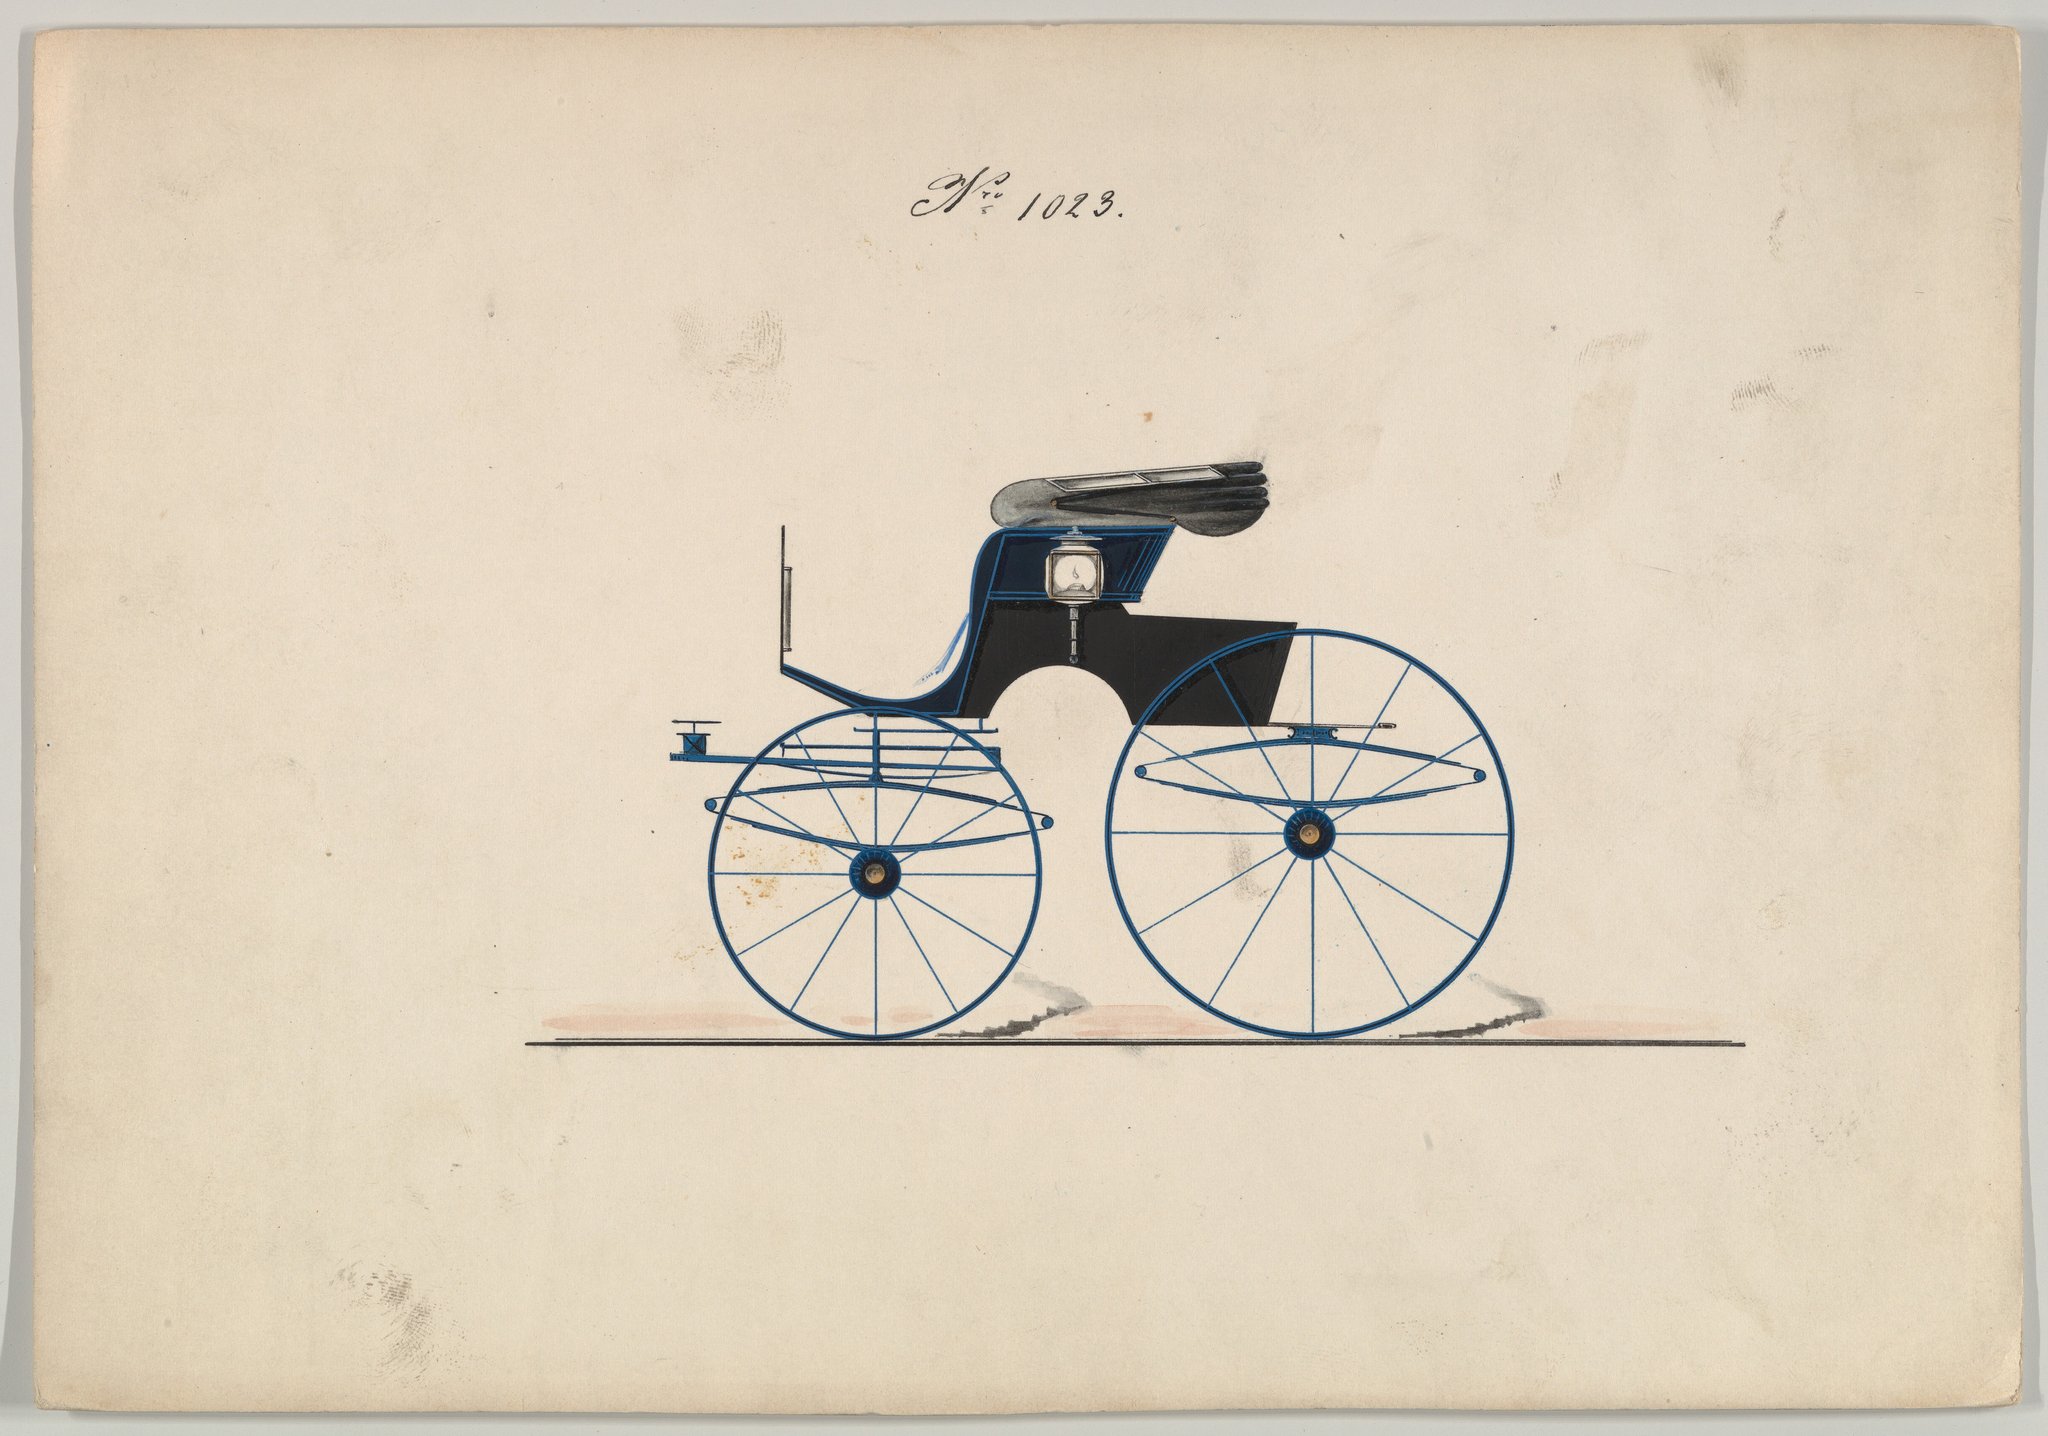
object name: drawing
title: Design for Unclassified Carriage, no. 1023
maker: brewster & co.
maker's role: manufacturer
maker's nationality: american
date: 1850-1870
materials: gouache, gum arabic, ink, watercolor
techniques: pen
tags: carriages